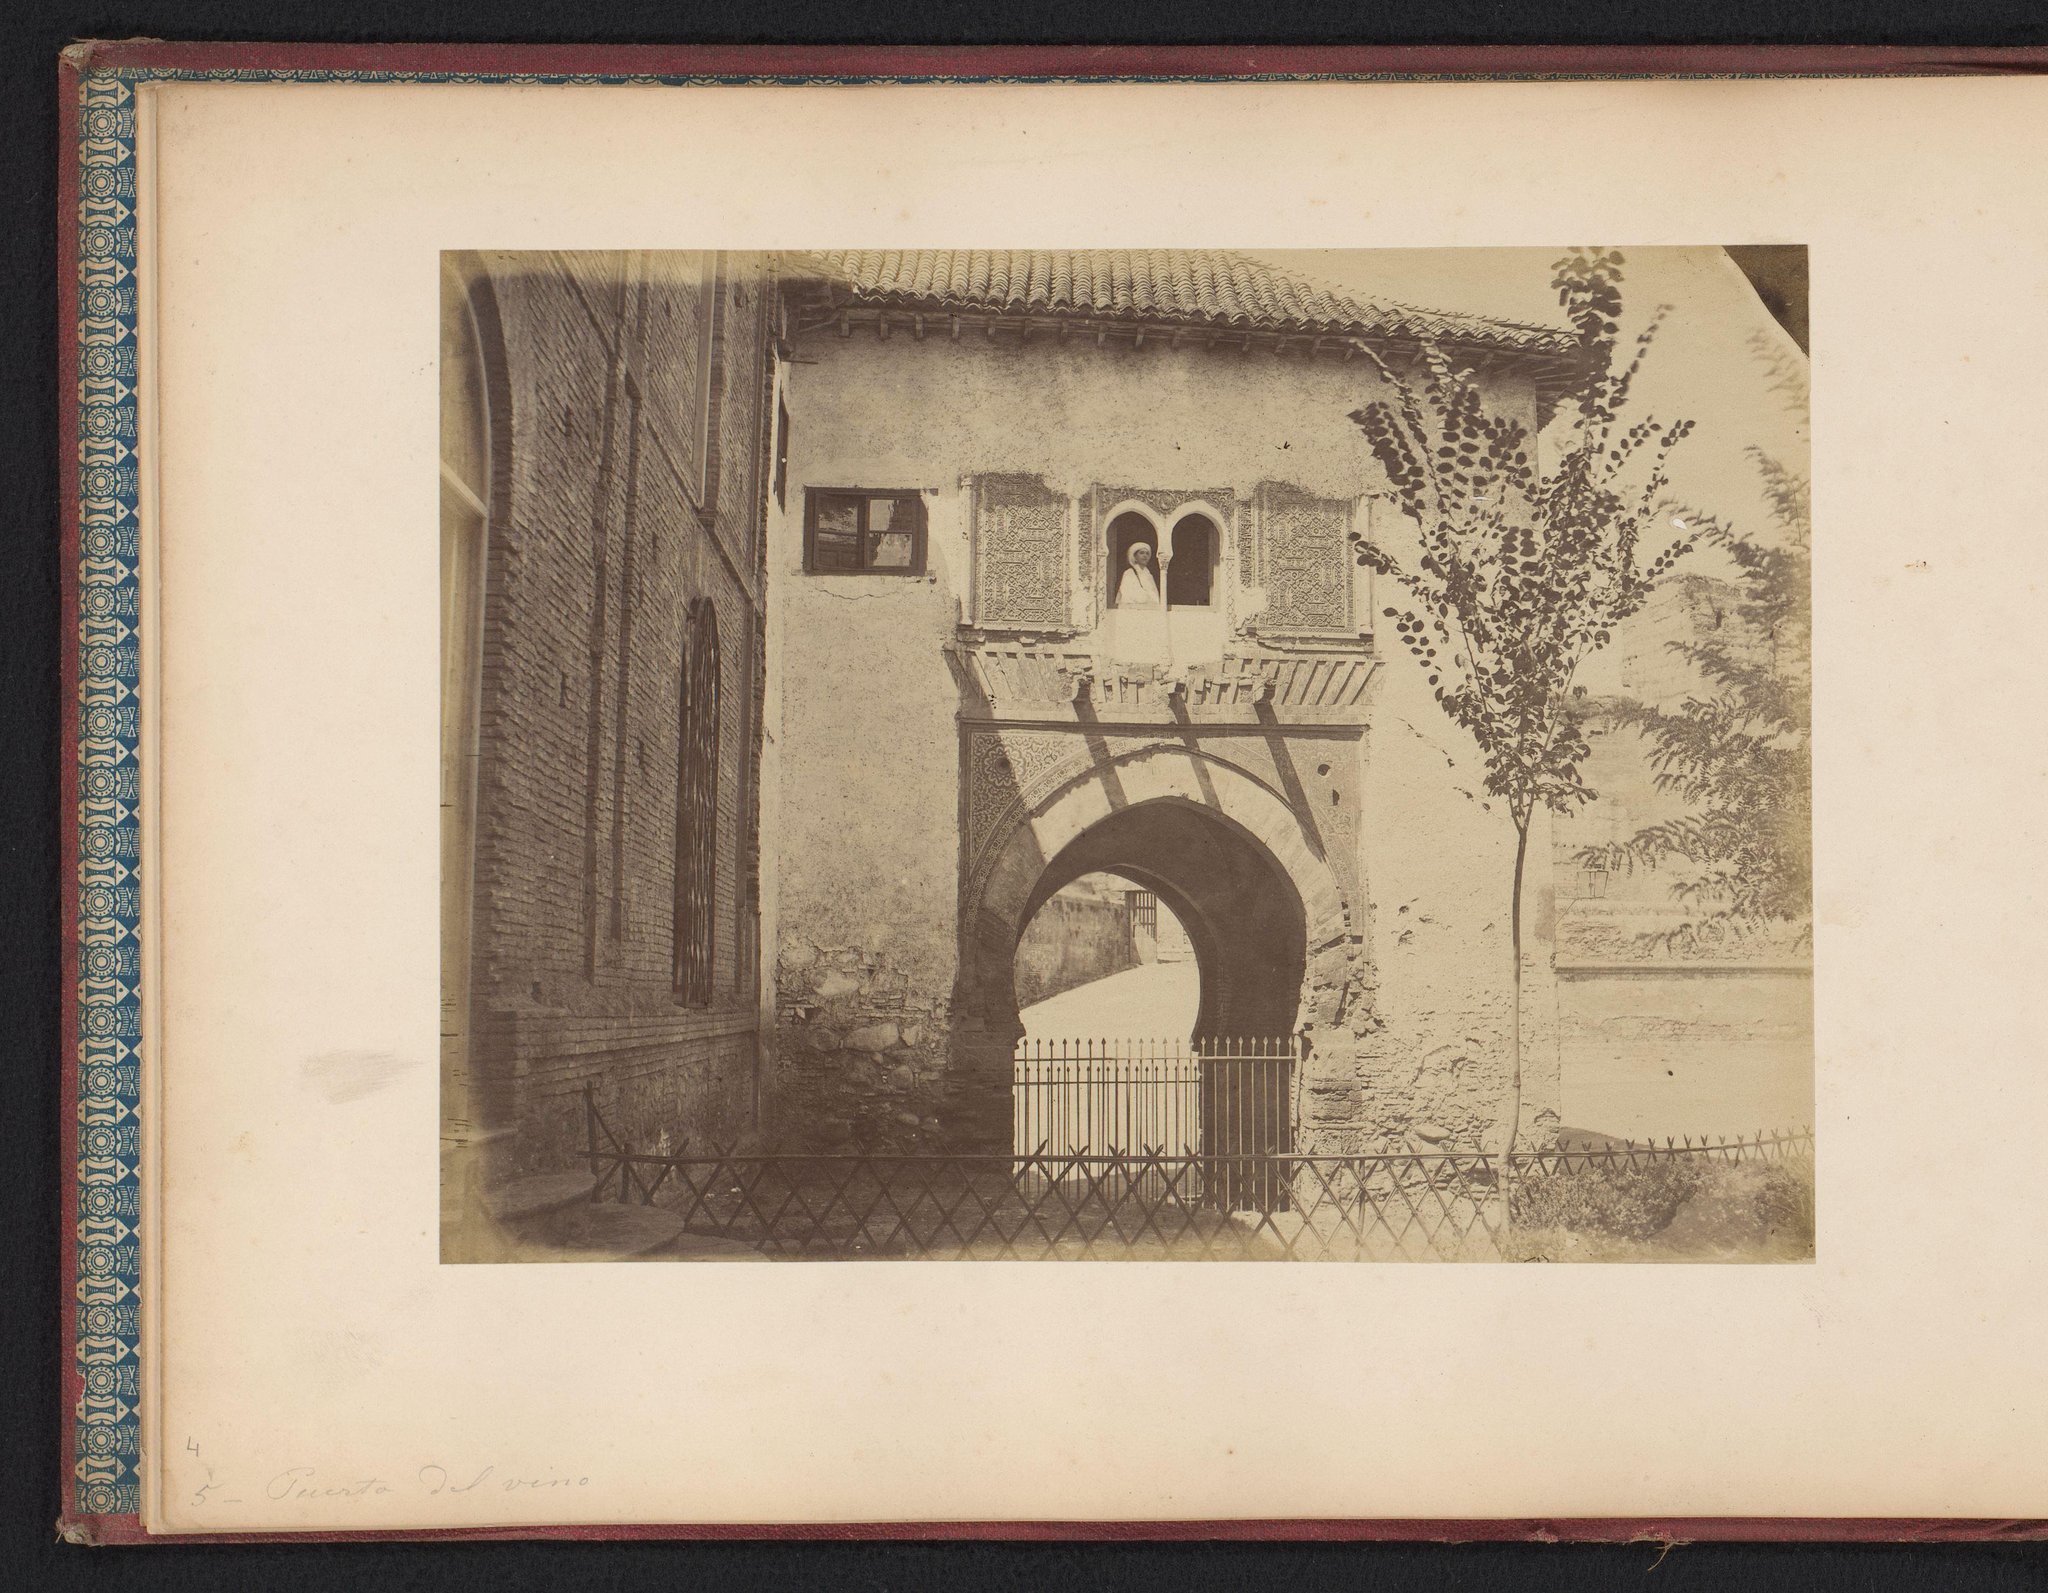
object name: album leaf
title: Gezicht op de Puerta del Vino in het Alhambra te Granada, Spanje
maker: c maufsaise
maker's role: fotograaf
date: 1906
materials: paper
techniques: albumen print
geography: granada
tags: gate ~ fortified city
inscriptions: number: ‘5’